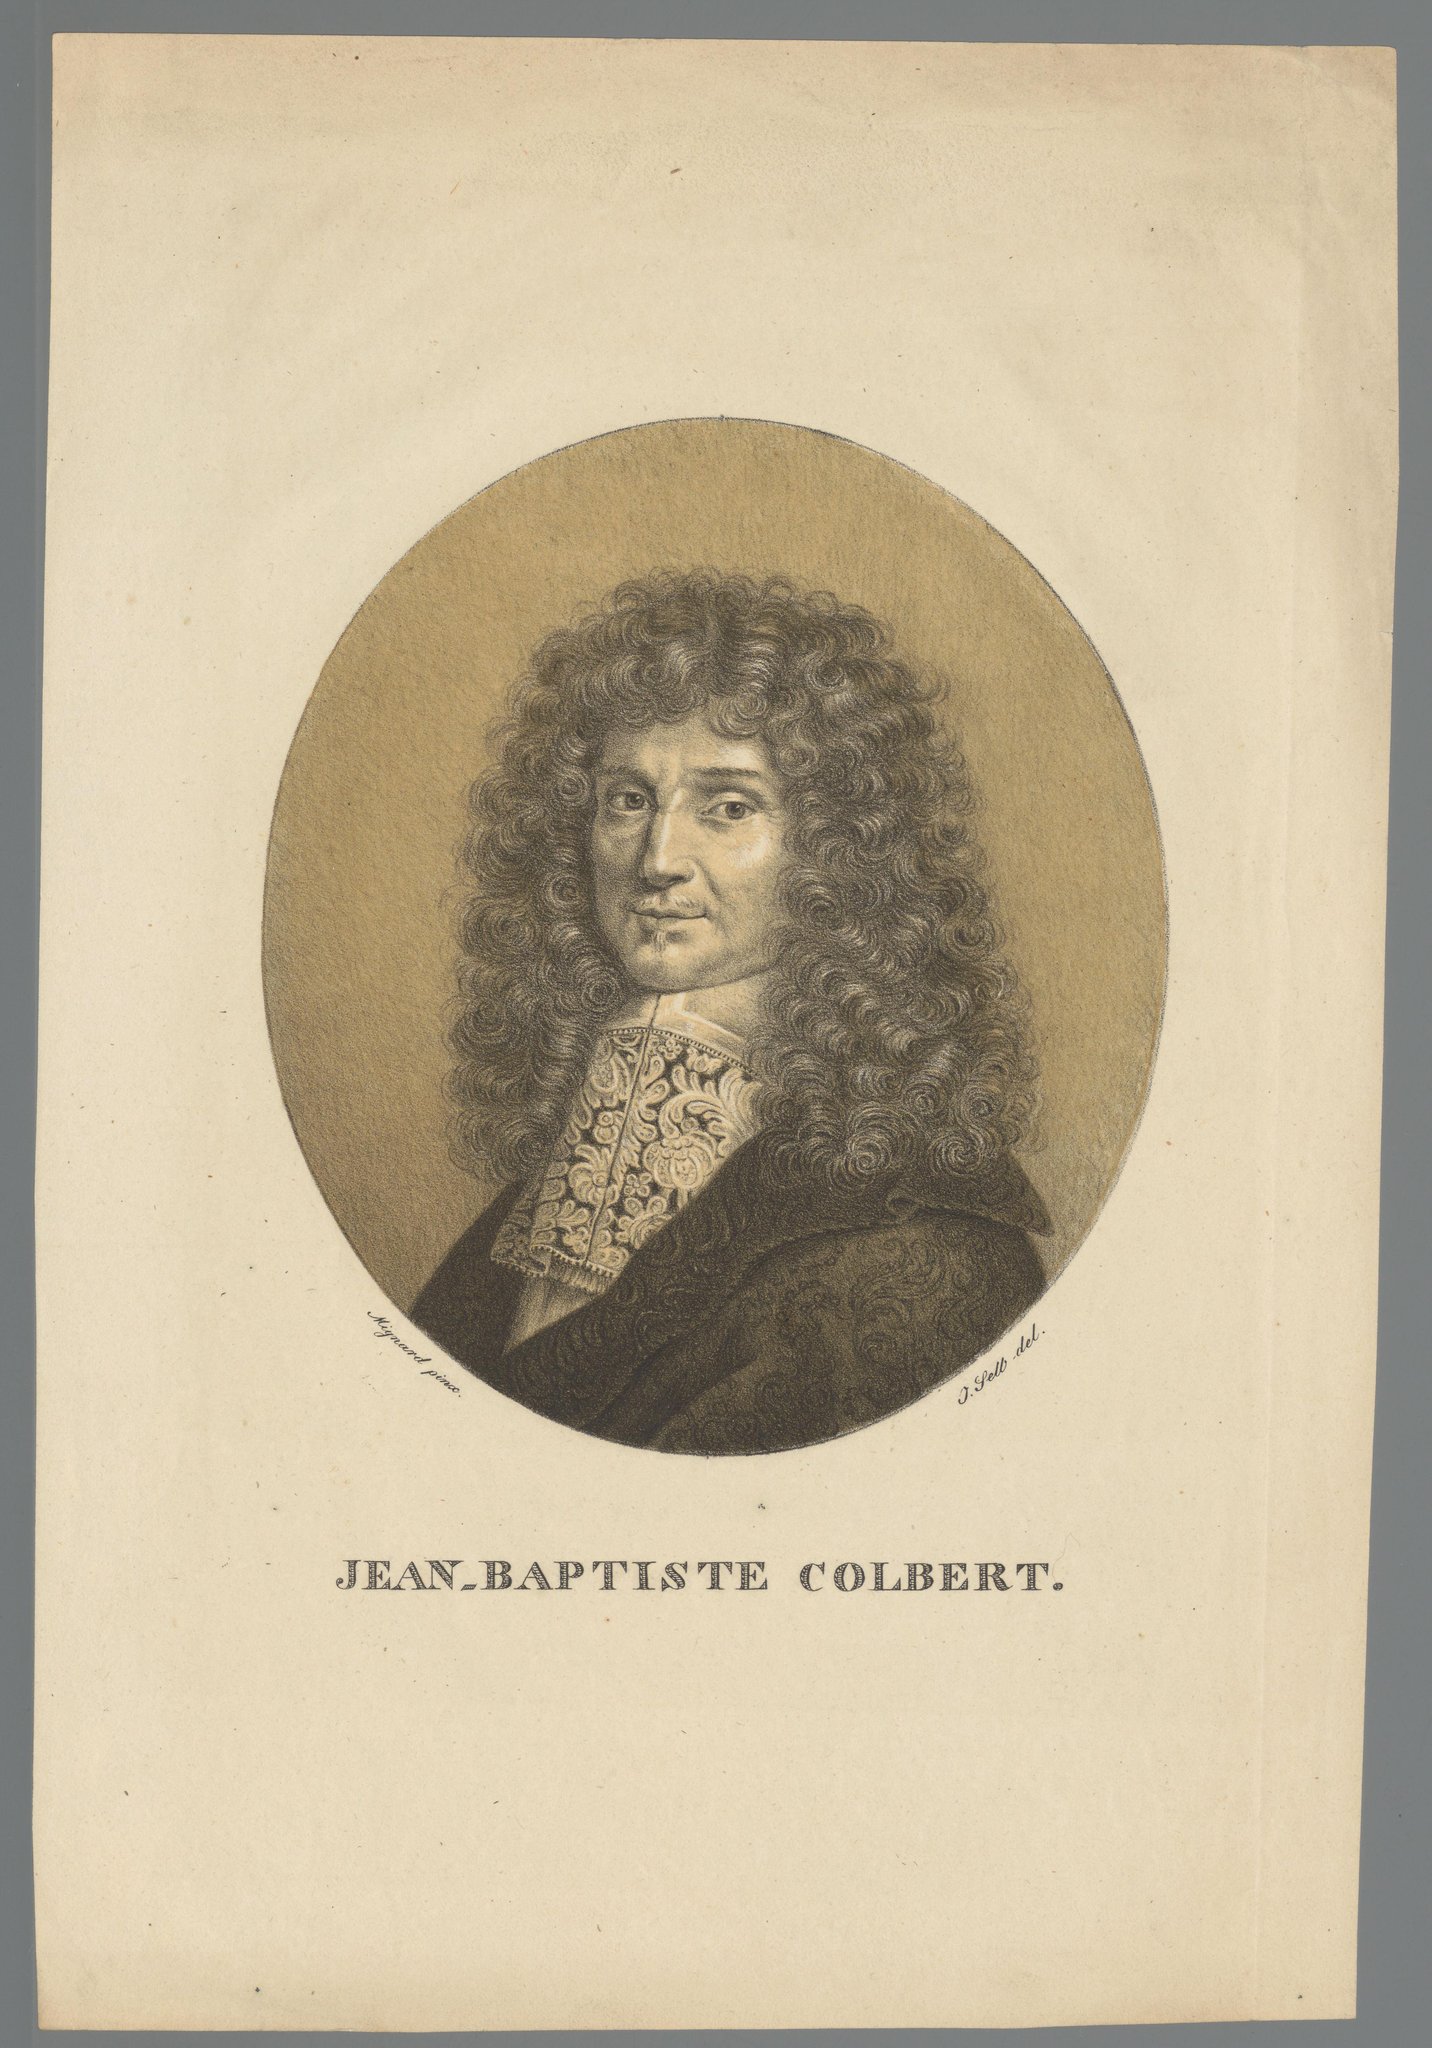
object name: print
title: Portret van Jean-Baptiste Colbert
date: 1814-1820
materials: paper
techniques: tone lithography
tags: paris, politician, jean-baptiste colbert, adult man, historical persons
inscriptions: collector's mark: Lugt 2228